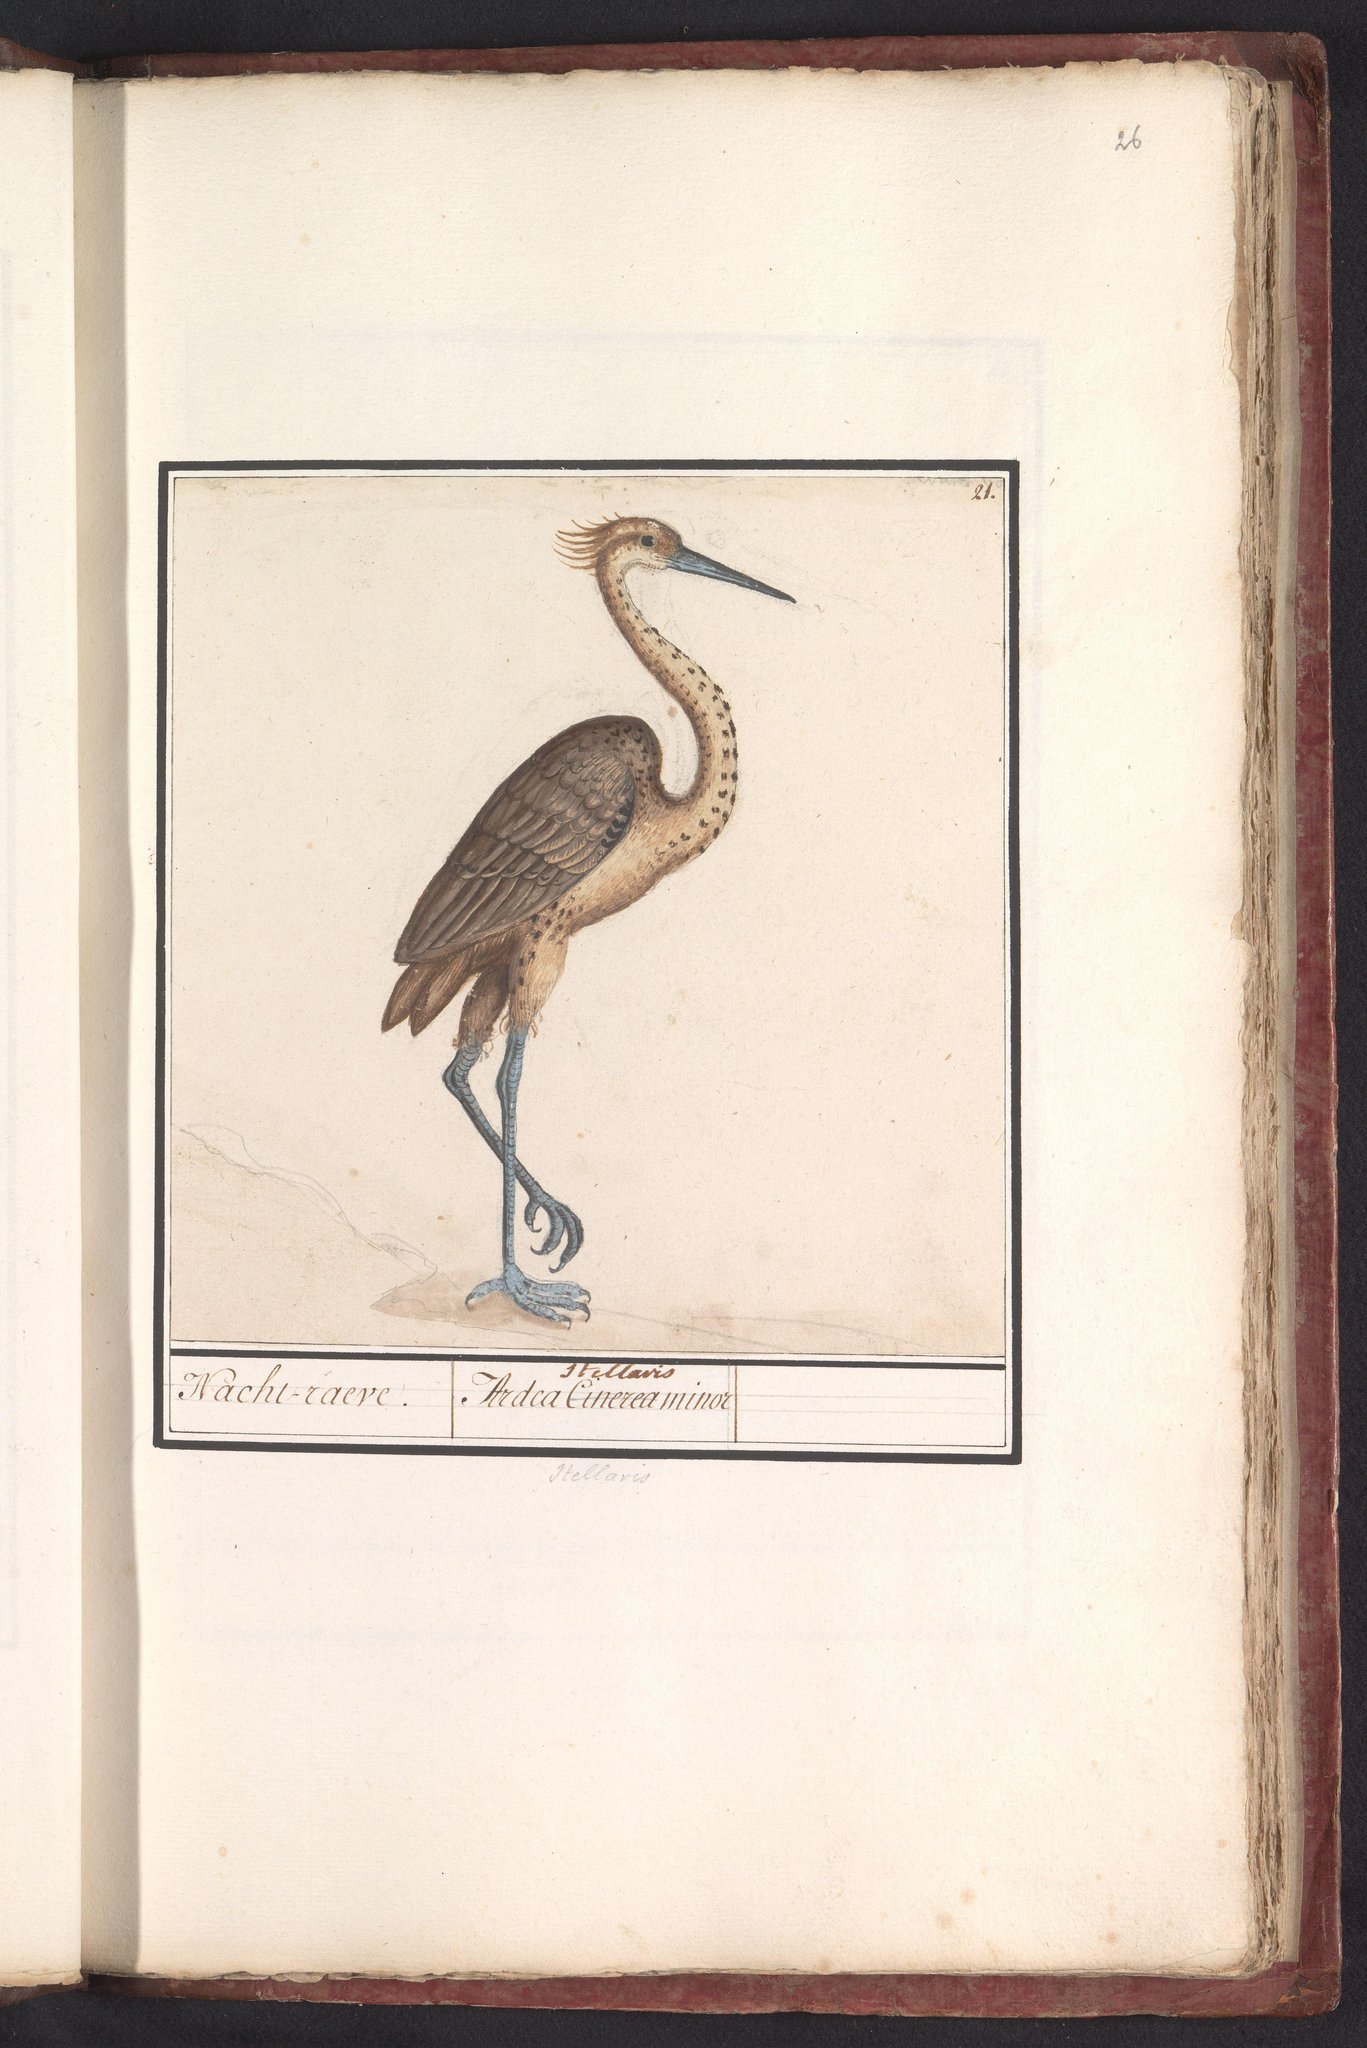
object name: drawing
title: Nacht-raeve. / Ardea Cinerea (Stellaris) minor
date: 1596-1610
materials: chalk, paint, paper, pencil, watercolor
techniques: brush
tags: shore-birds and wading-birds: purple heron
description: Een reiger, mogelijk een purperreiger. Genummerd rechtsboven: 21. Onderdeel van het derde album met tekeningen van vogels. Vijfde van twaalf albums met tekeningen van dieren, vogels en planten bekend rond 1600, gemaakt in opdracht van keizer Rudolf II. Met toelichting in Nederlands, Latijn en Frans.